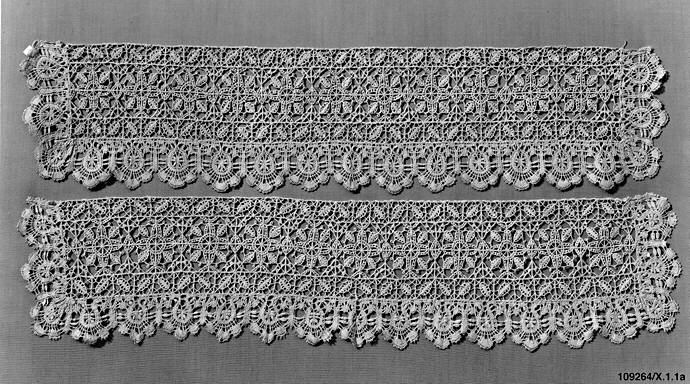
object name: cuff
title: Cuff (one of a pair)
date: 1501-1600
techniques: lace